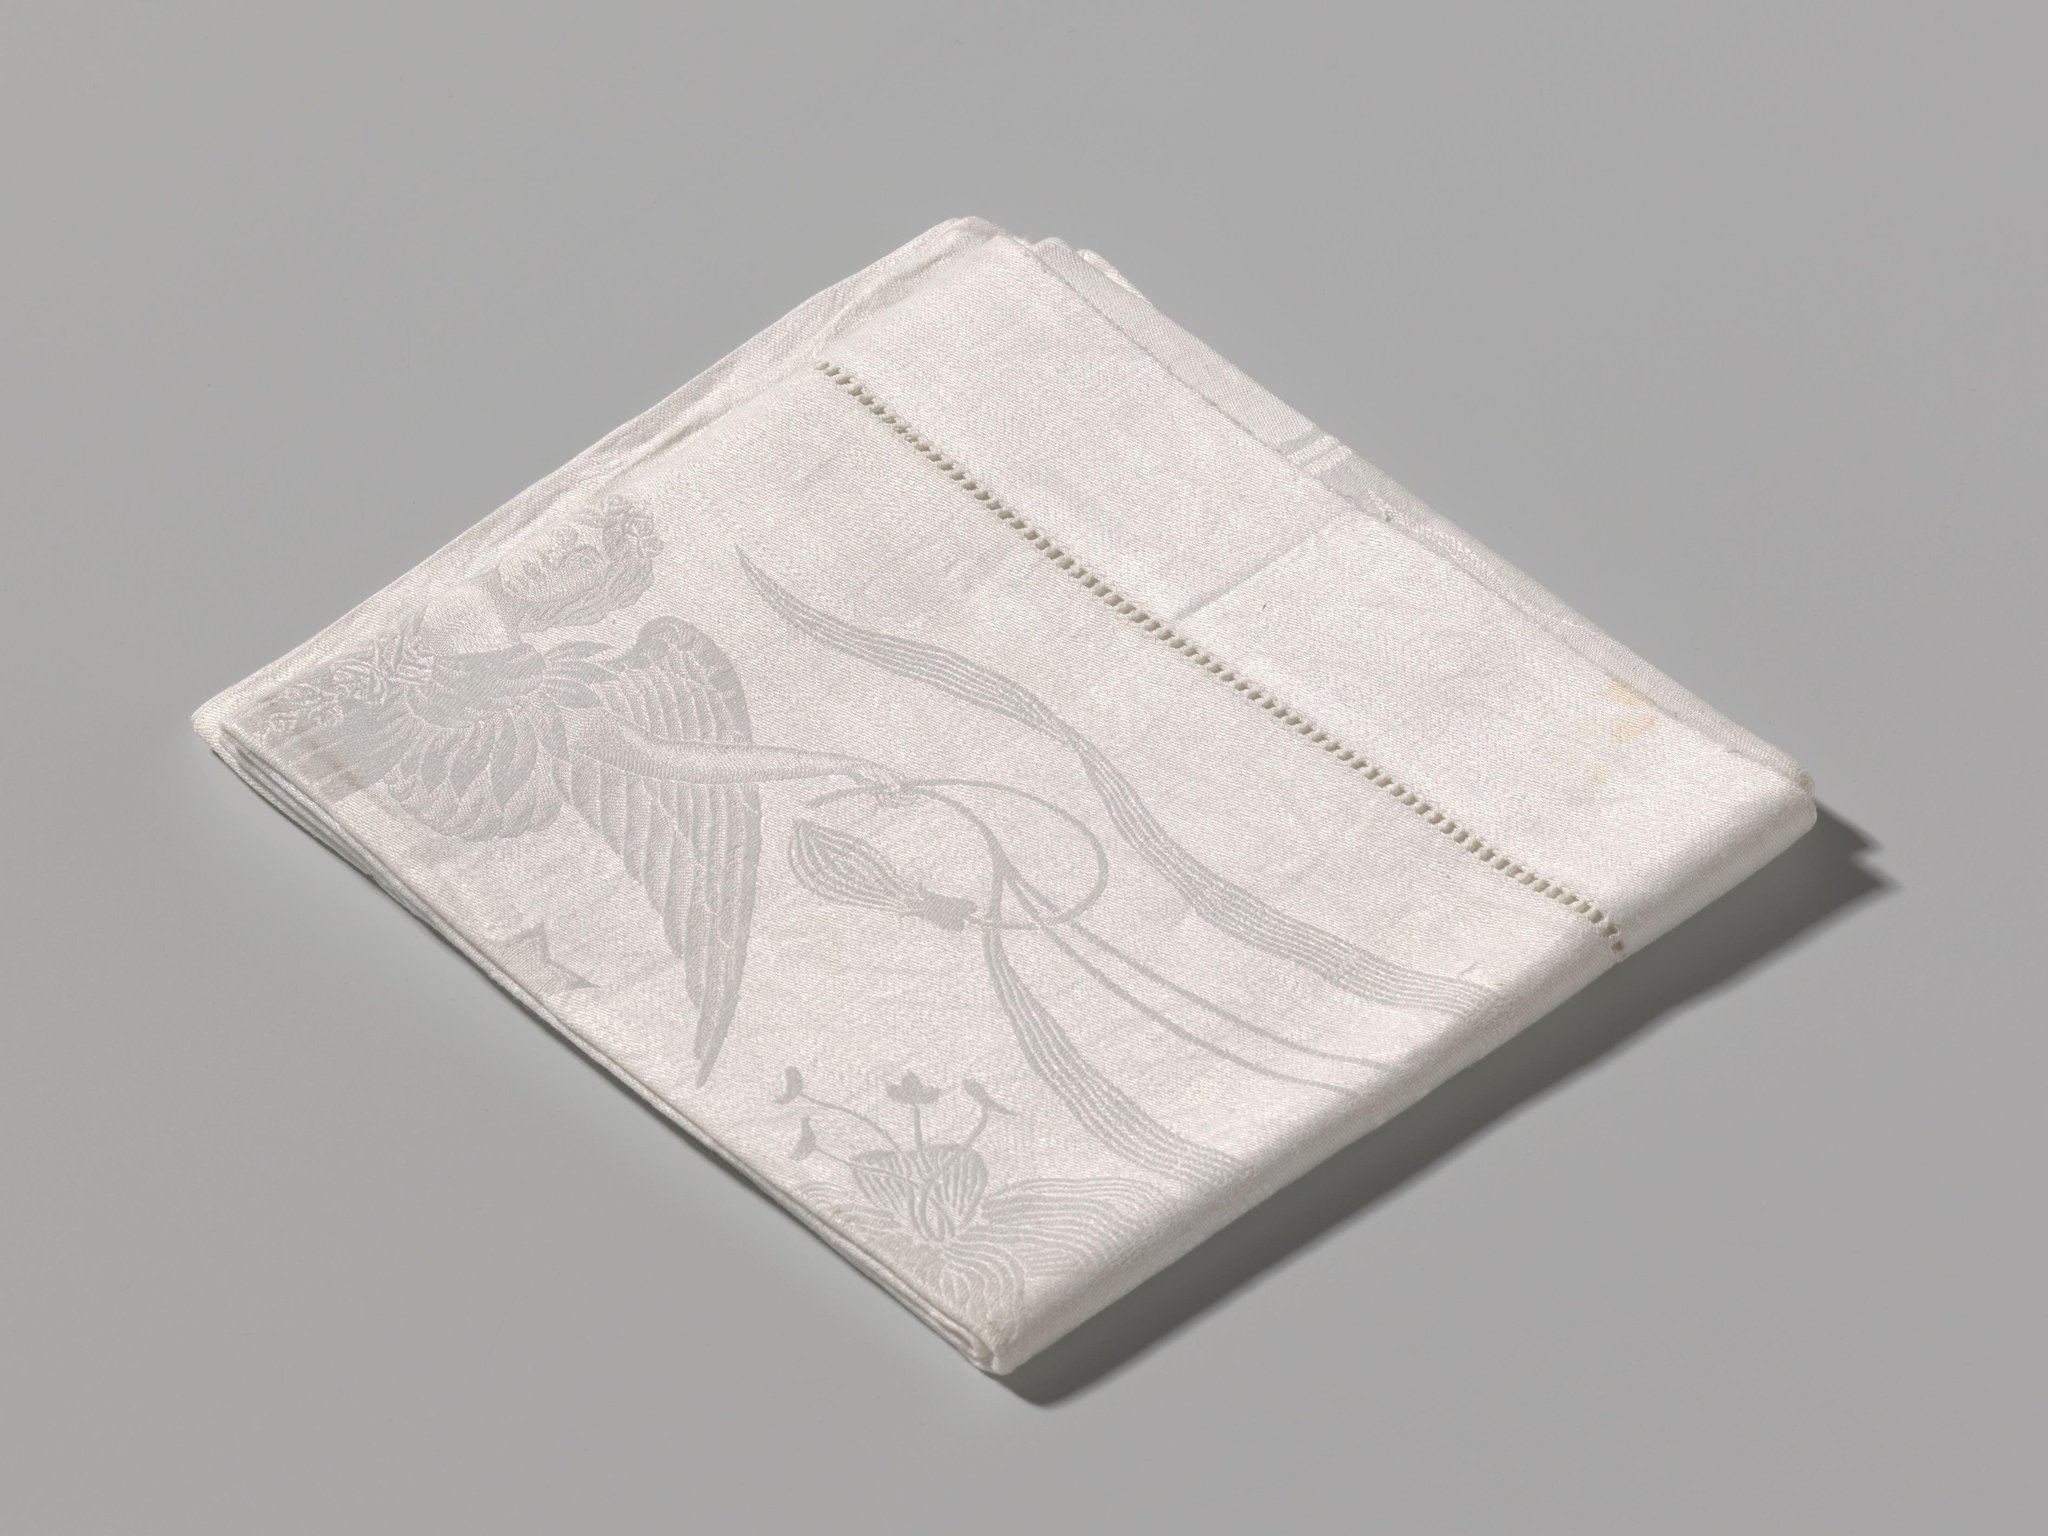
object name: napkin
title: Servet met gevlamde zon, sterren, engelen en bloemen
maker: Anonymous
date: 1900-1920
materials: linen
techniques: damask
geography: germany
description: Wit linnen damasten servet met een Jugendstil-patroon, gevlamde zon, sterren, engelen en bloemen.